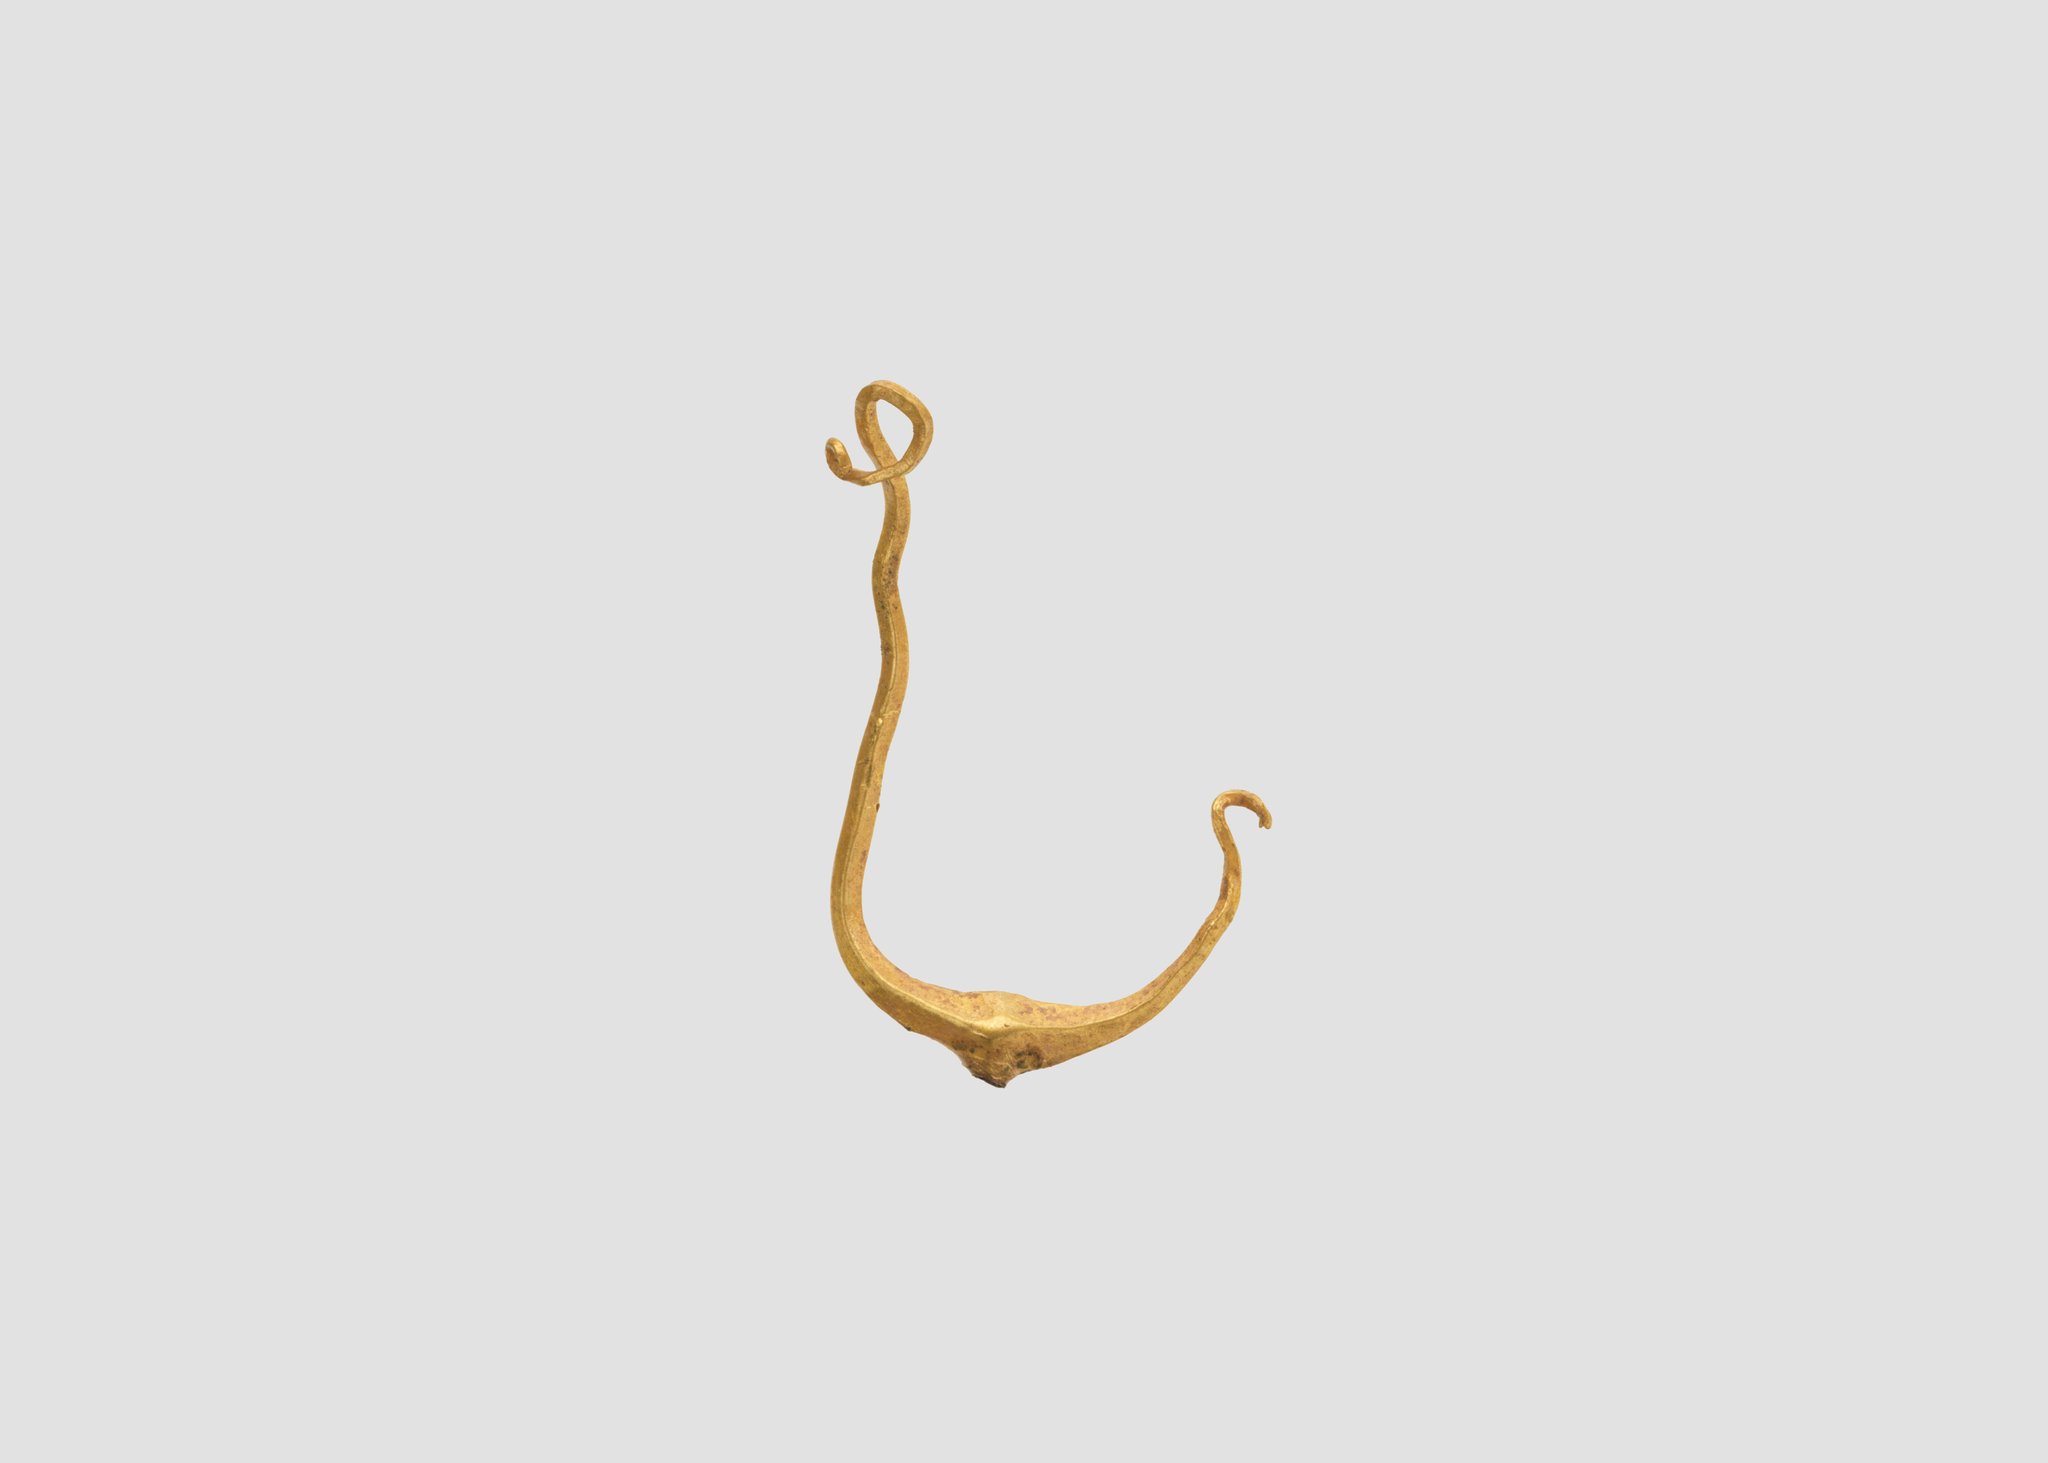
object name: earring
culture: sasanian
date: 201-700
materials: gold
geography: iran